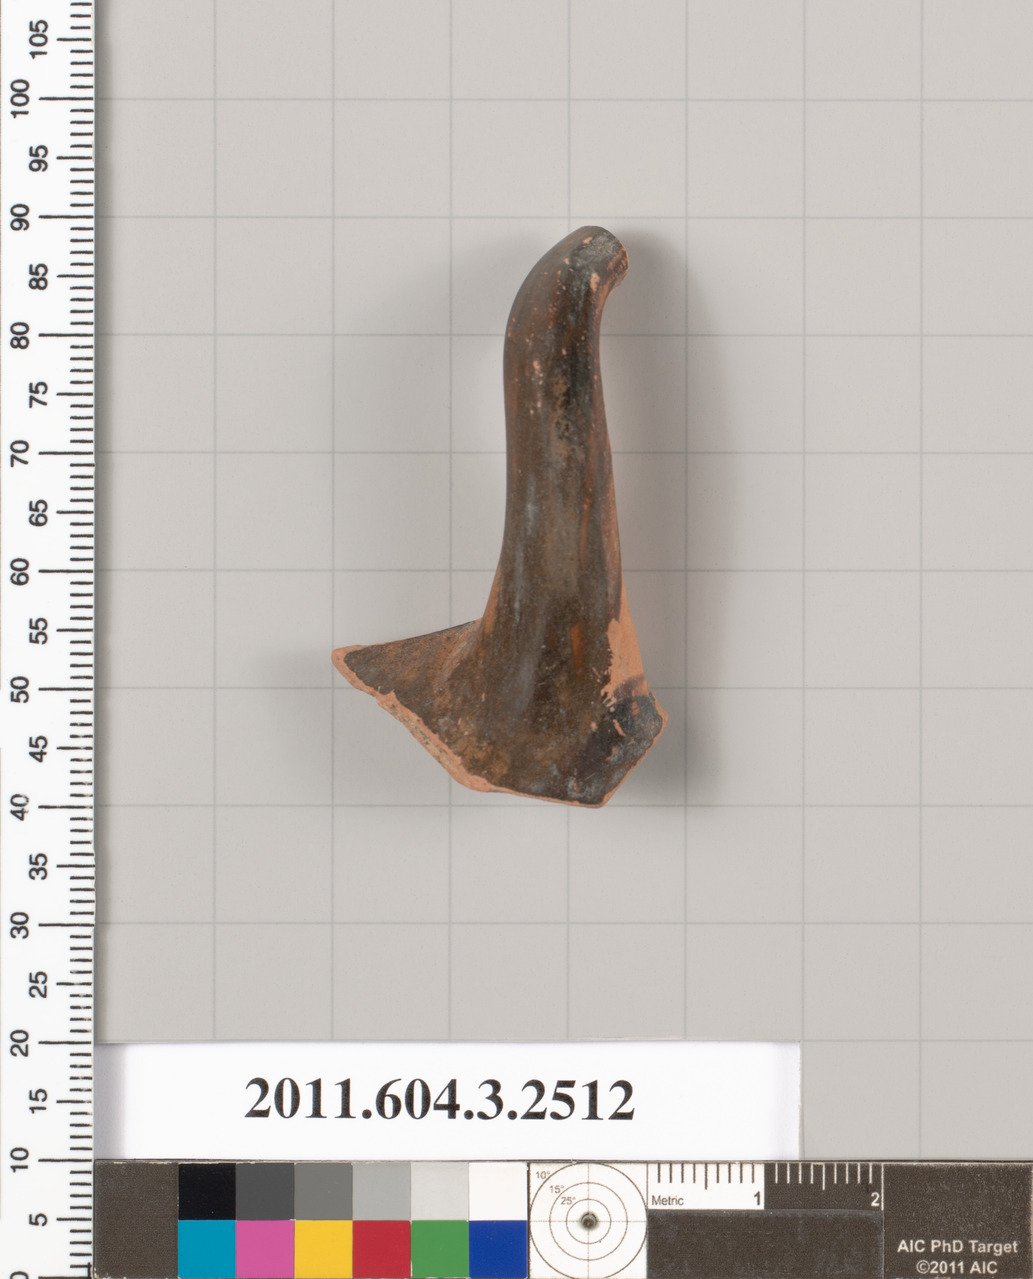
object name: kylix fragment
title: Terracotta fragment of a kylix (drinking cup)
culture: greek, attic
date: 600-401 BCE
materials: terracotta